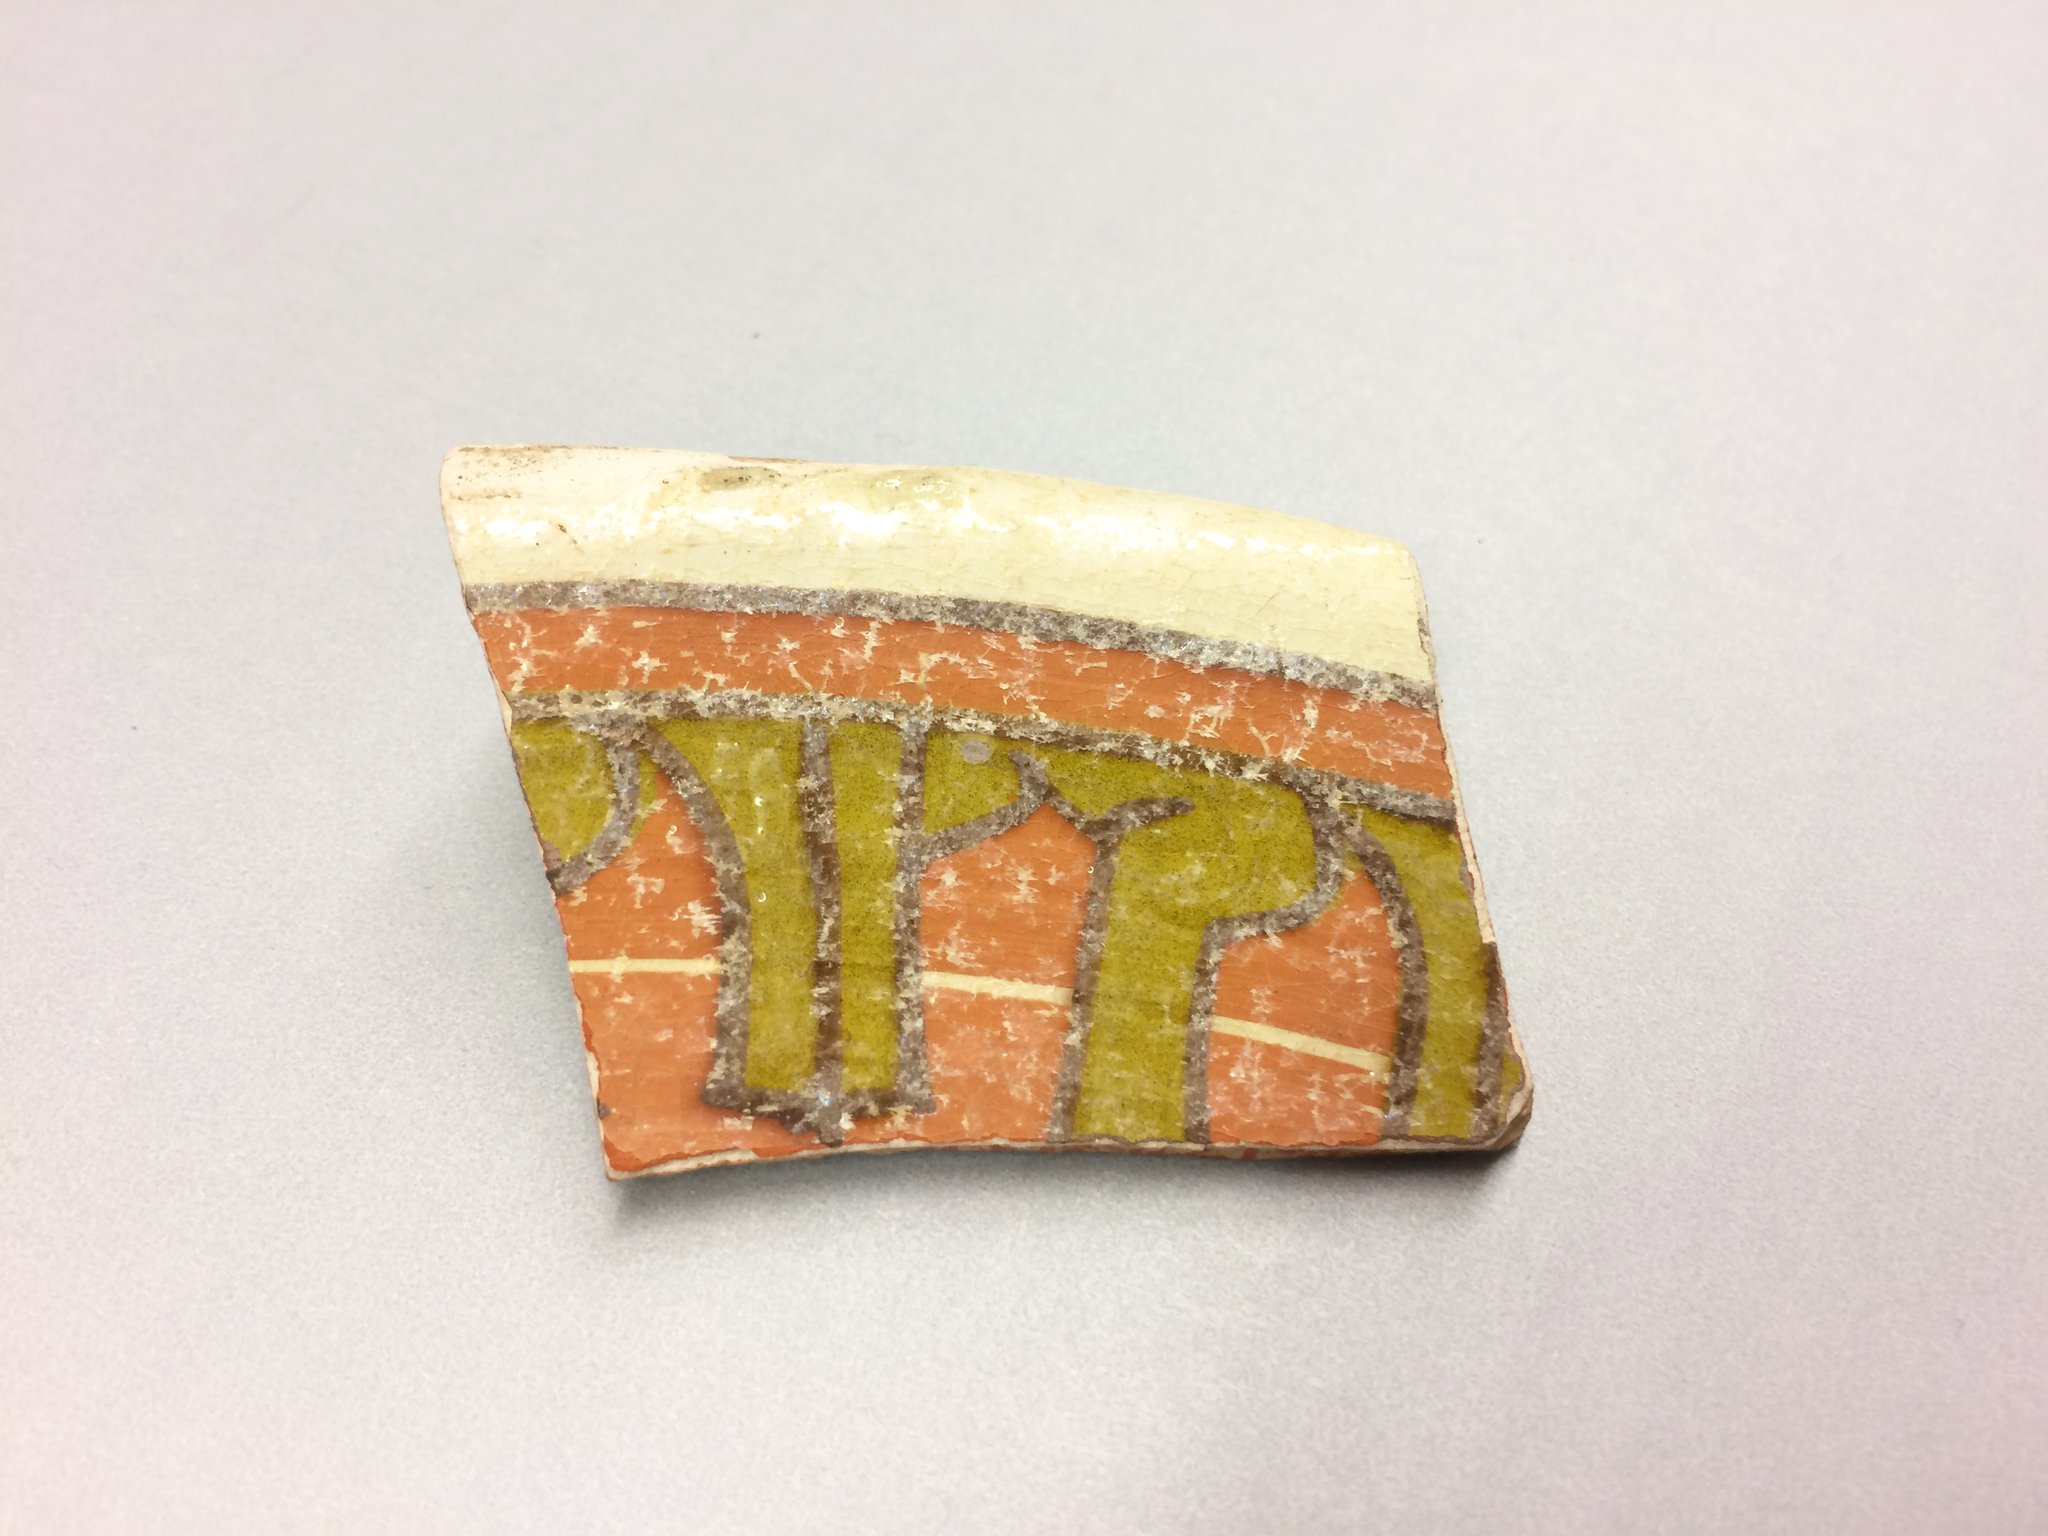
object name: fragment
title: Ceramic Fragment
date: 801-1000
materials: earthenware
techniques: painting, underglaze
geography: iran